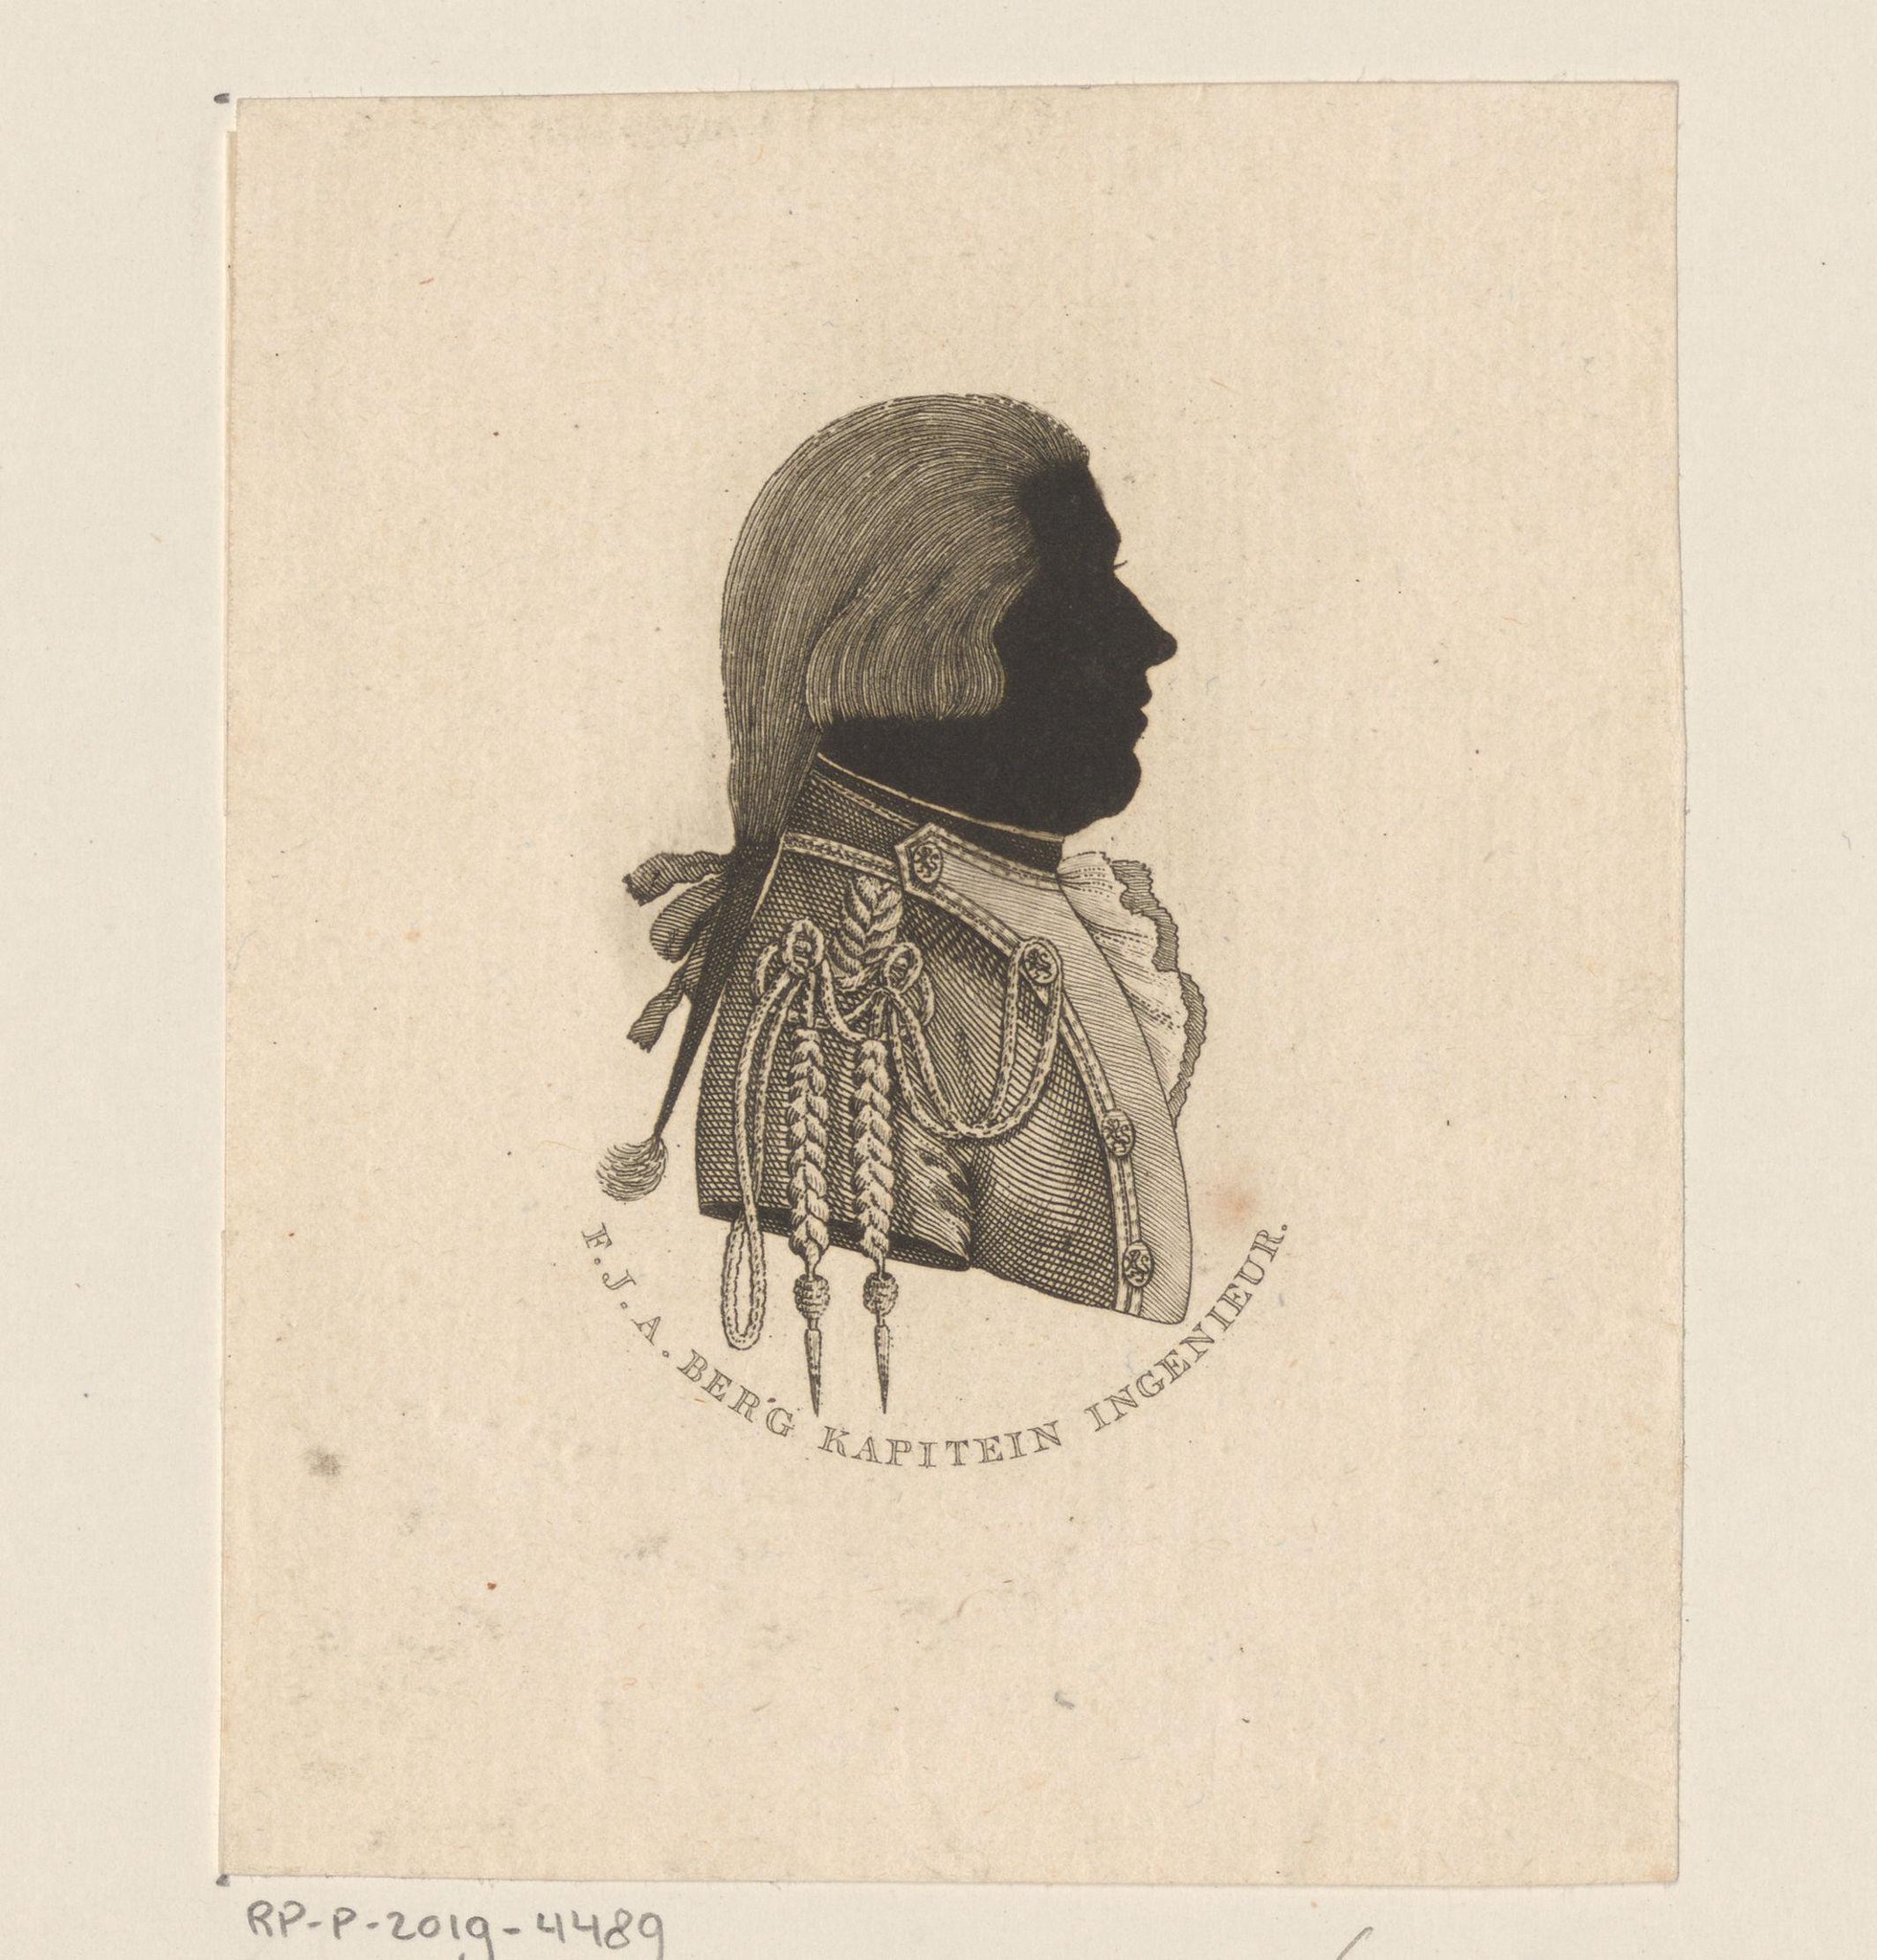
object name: print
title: Silhouetportret van Frans Jacob Alexander Berg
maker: Anonymous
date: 1793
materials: paper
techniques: engraving, etching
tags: engineer, historical persons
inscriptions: collector's mark: Lugt 2228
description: Prent met tekst op verso verschenen in: Oldenborgh, Pieter van. De belegering en verdediging van de Willemstad in Maart 1793. Dordrecht: Abraham Blussé & Zoon, Amsterdam: Johannes Allart, 1793.